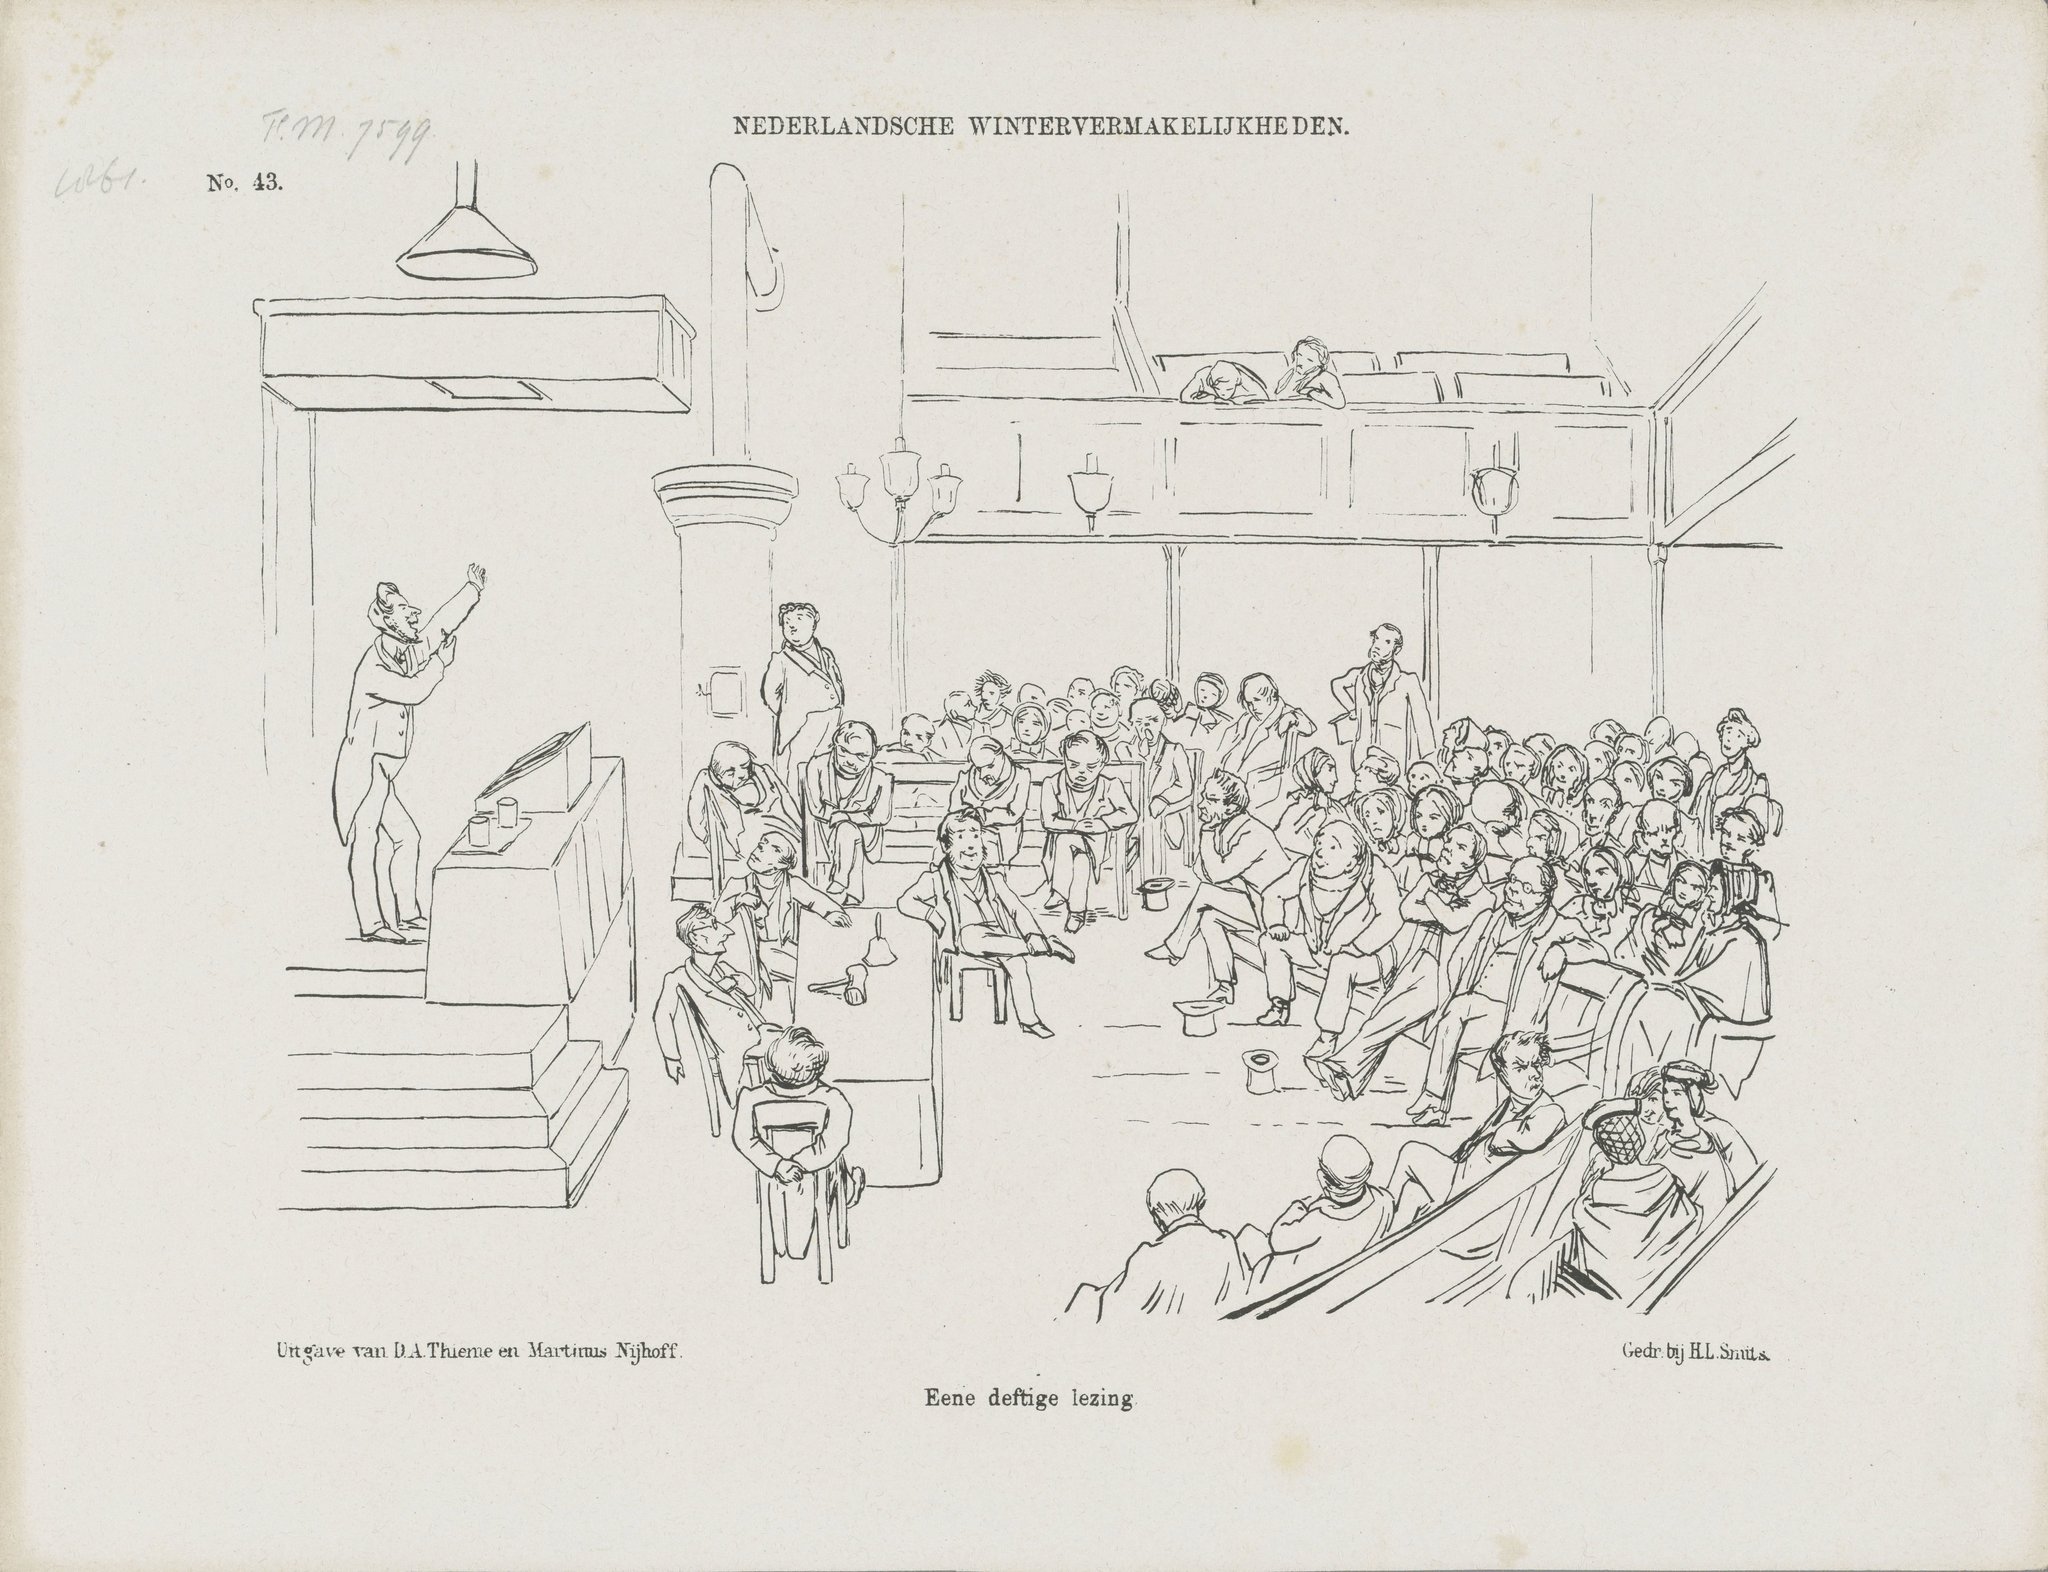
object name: print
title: Spotprent op lezingen in deftige genootschappen, 1861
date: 1861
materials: paper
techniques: lithograph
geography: netherlands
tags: address, talk, lecture (~ meeting), learned society, academy of sciences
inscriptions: collector's mark: Lugt 2228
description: Spotprent op de lezingen gehouden in genootschappen zoals de Maatschappij tot Nut van 't Algemeen. Zaal waarin een spreker een lezing houdt voor een publiek dat deels luistert en deels met andere zaken bezig is. Plaat verschenen bij het weekblad De Nederlandsche Spectator, nr. 43, 26 oktober 1861.